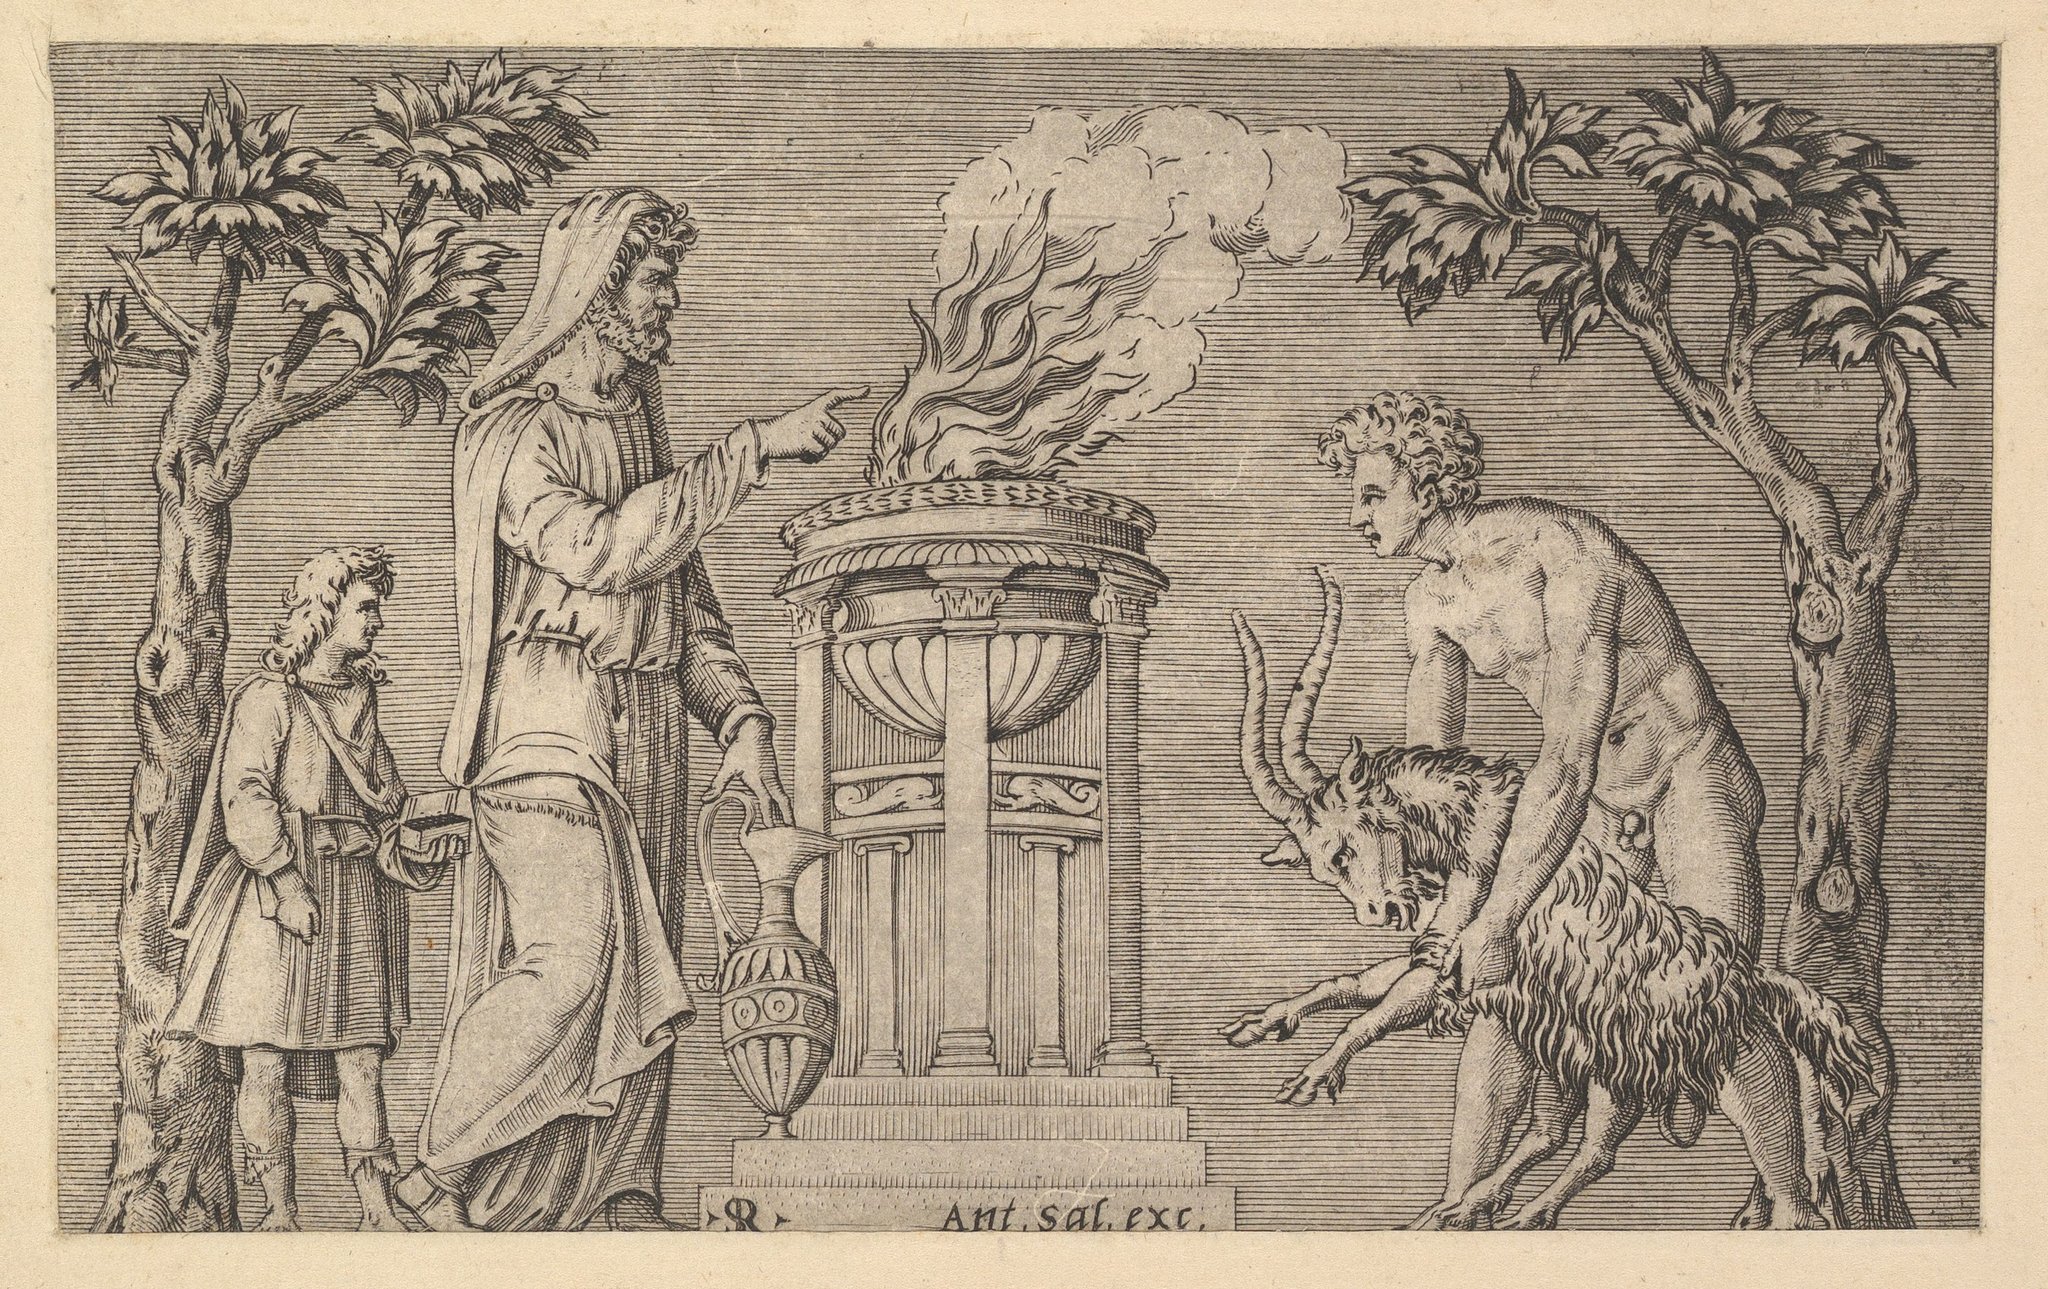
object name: print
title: The Sacrifice of a Ram, from "Speculum Romanae Magnificentiae"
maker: marco dente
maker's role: artist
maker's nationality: italian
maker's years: 1515-1527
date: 1501-1600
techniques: engraving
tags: men,male nudes,rams,fire,trees